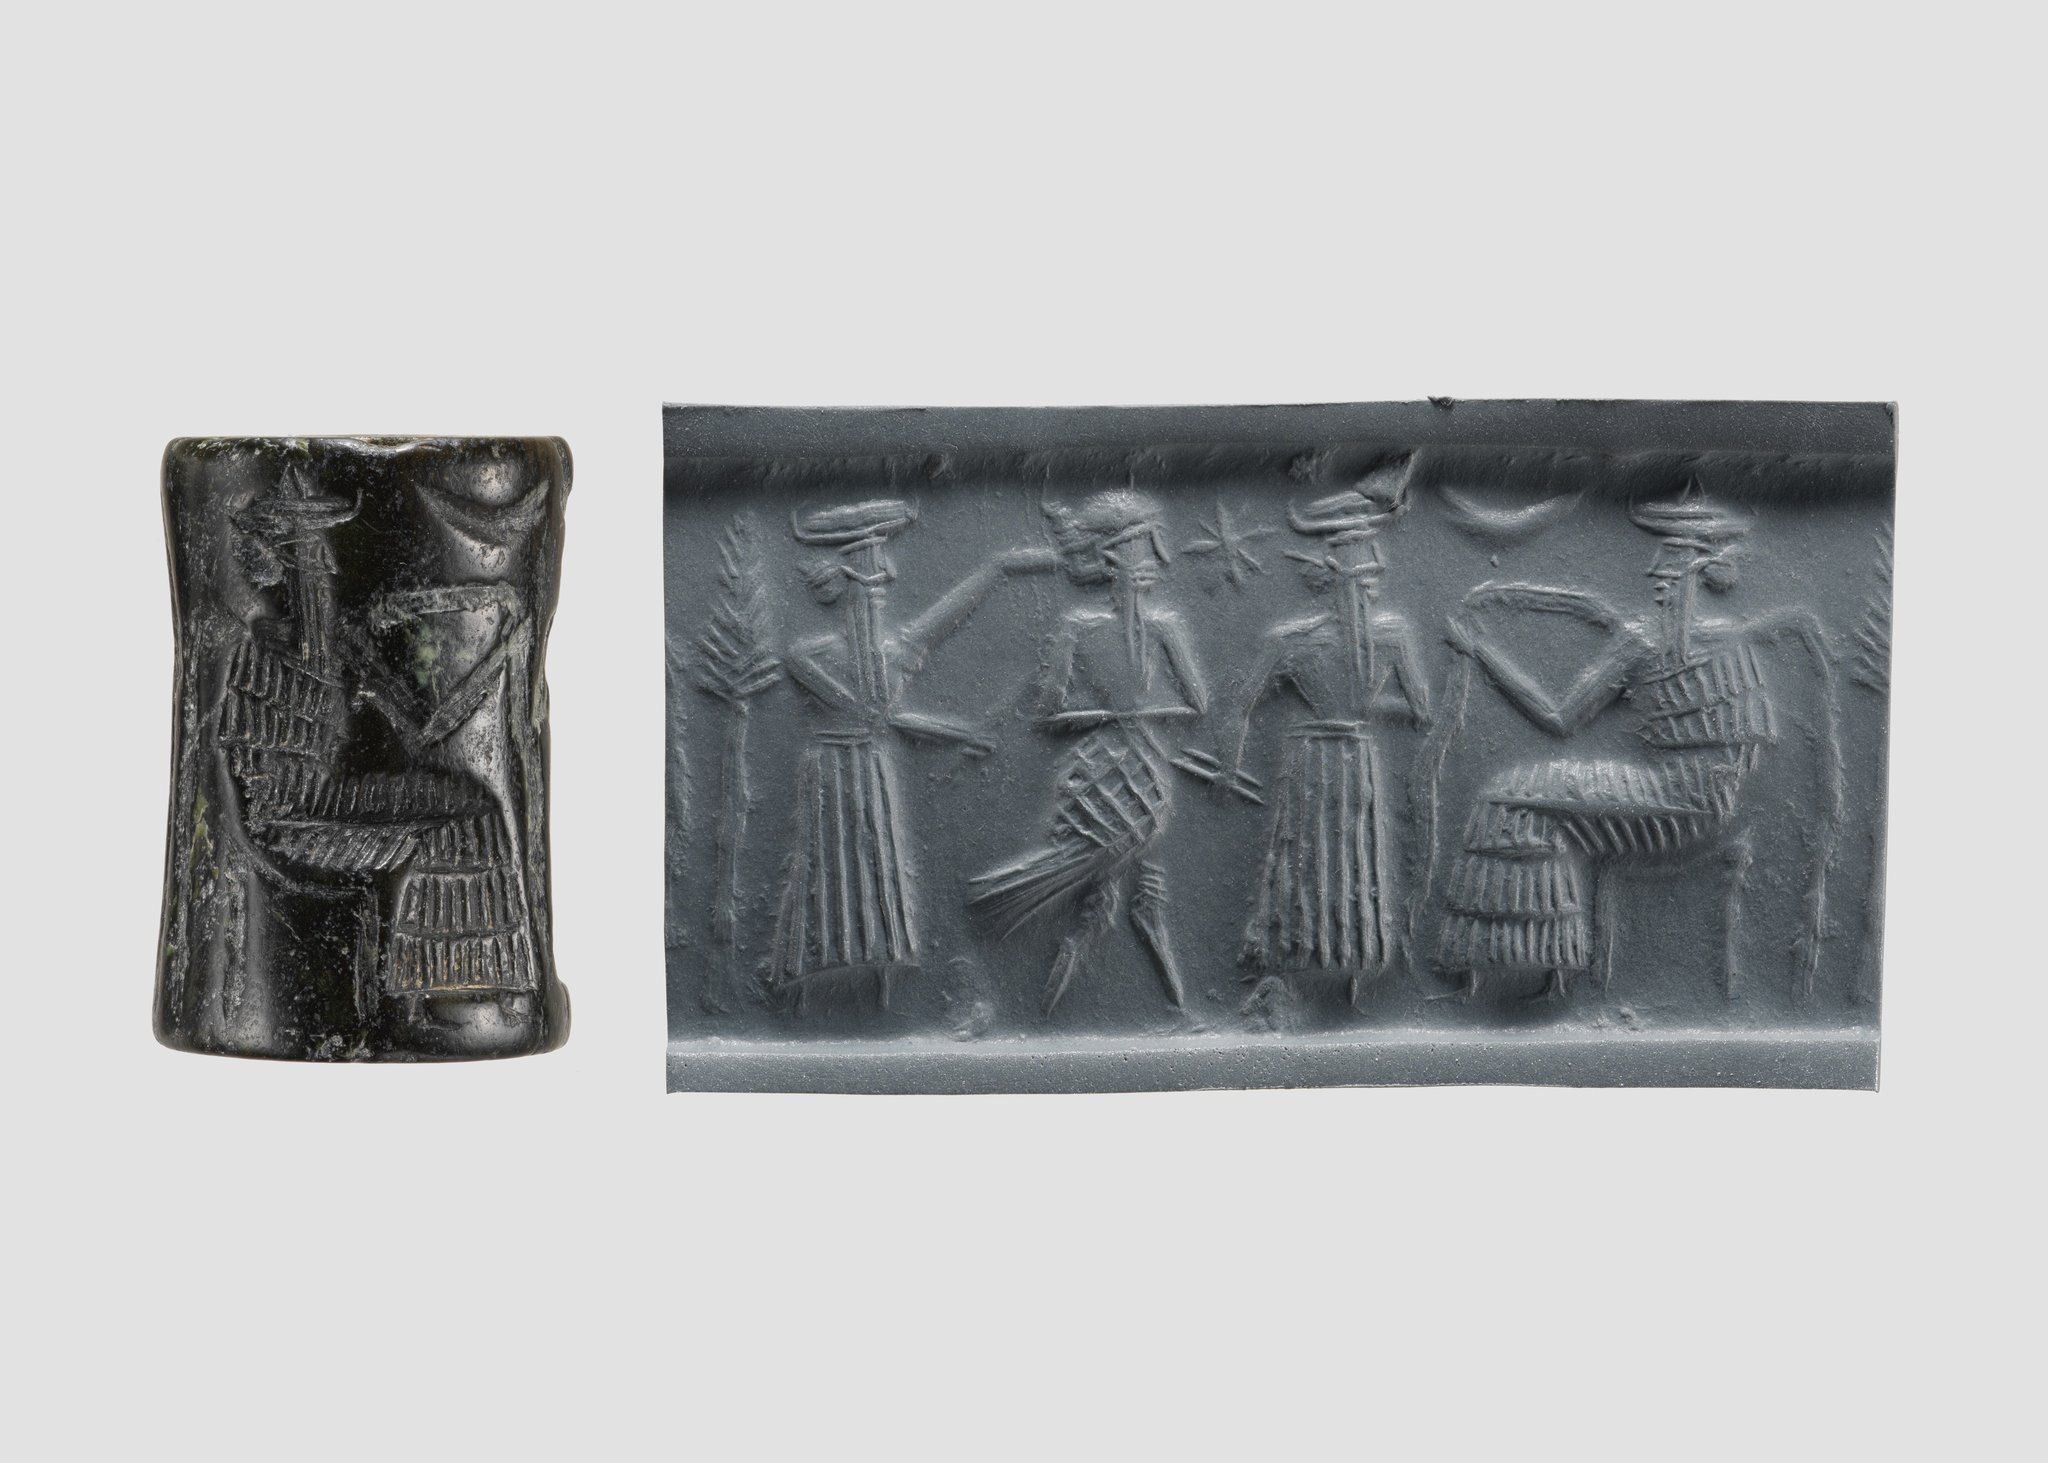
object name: cylinder seal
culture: akkadian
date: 2350-2150 BCE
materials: stone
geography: mesopotamia